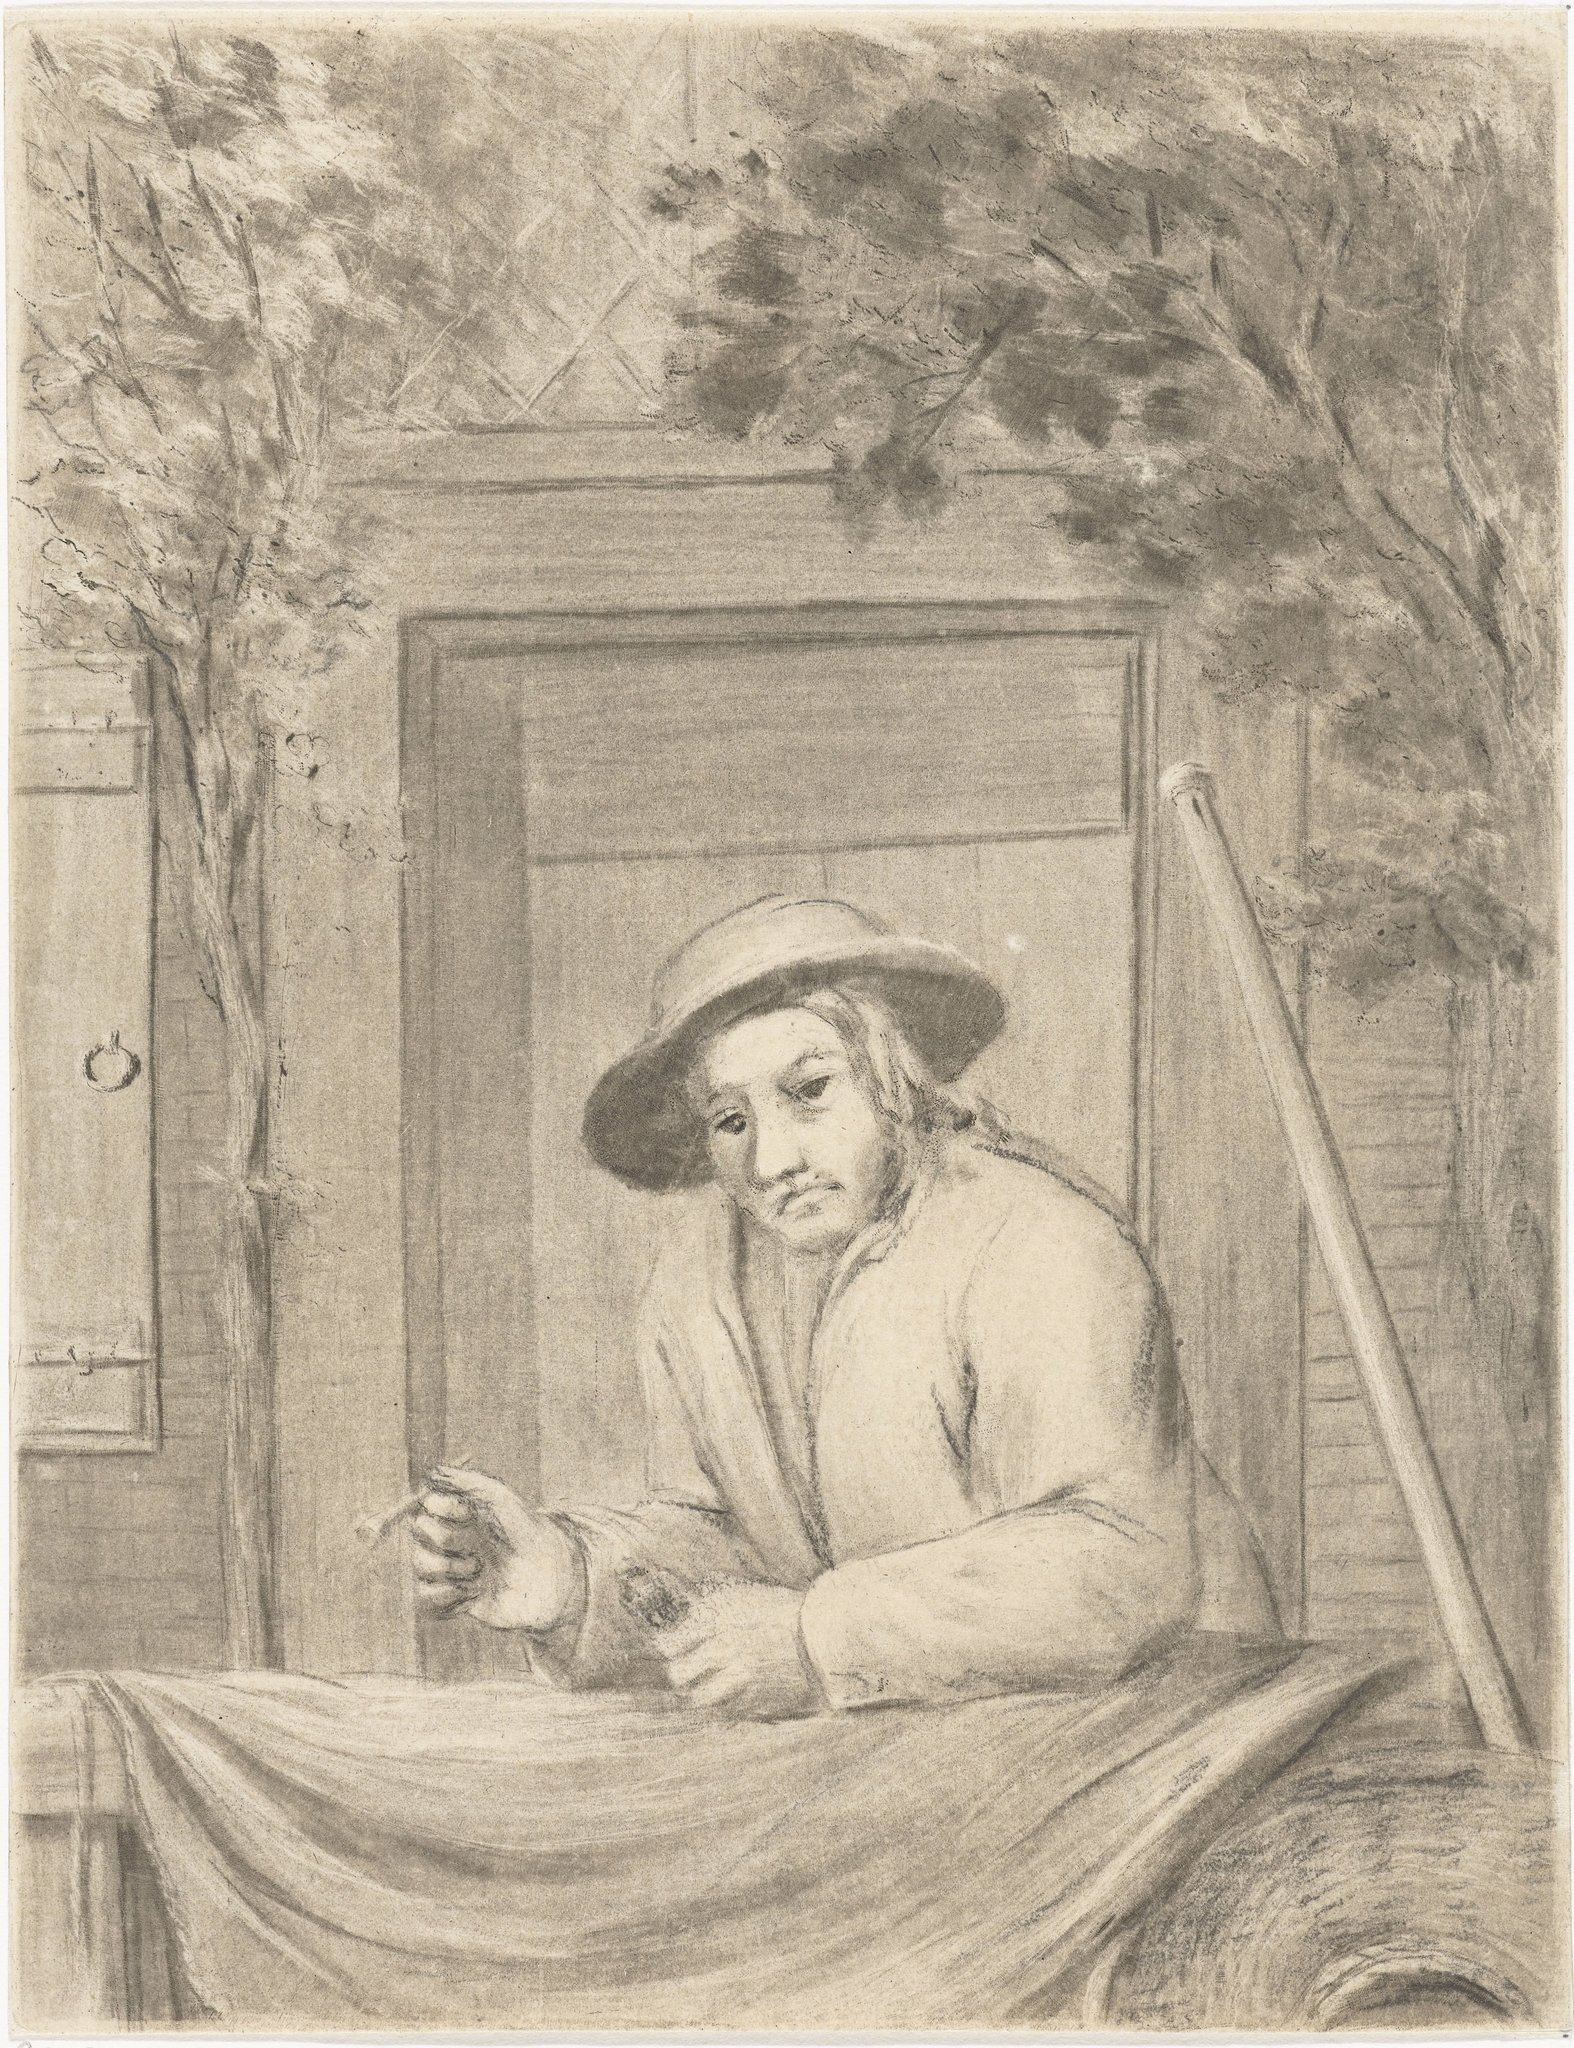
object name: print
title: Rokende boer met pijp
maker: jurriaan cootwijck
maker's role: print maker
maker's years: 1714-1798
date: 1724-1798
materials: paper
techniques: print drawing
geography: amsterdam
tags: pipe ~ tobacco, farmers, human figure at (open) window, seen from outside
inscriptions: collector's mark: Lugt 2228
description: Boer met pijp in een raamopening. Hij heeft een glas in zijn andere hand.